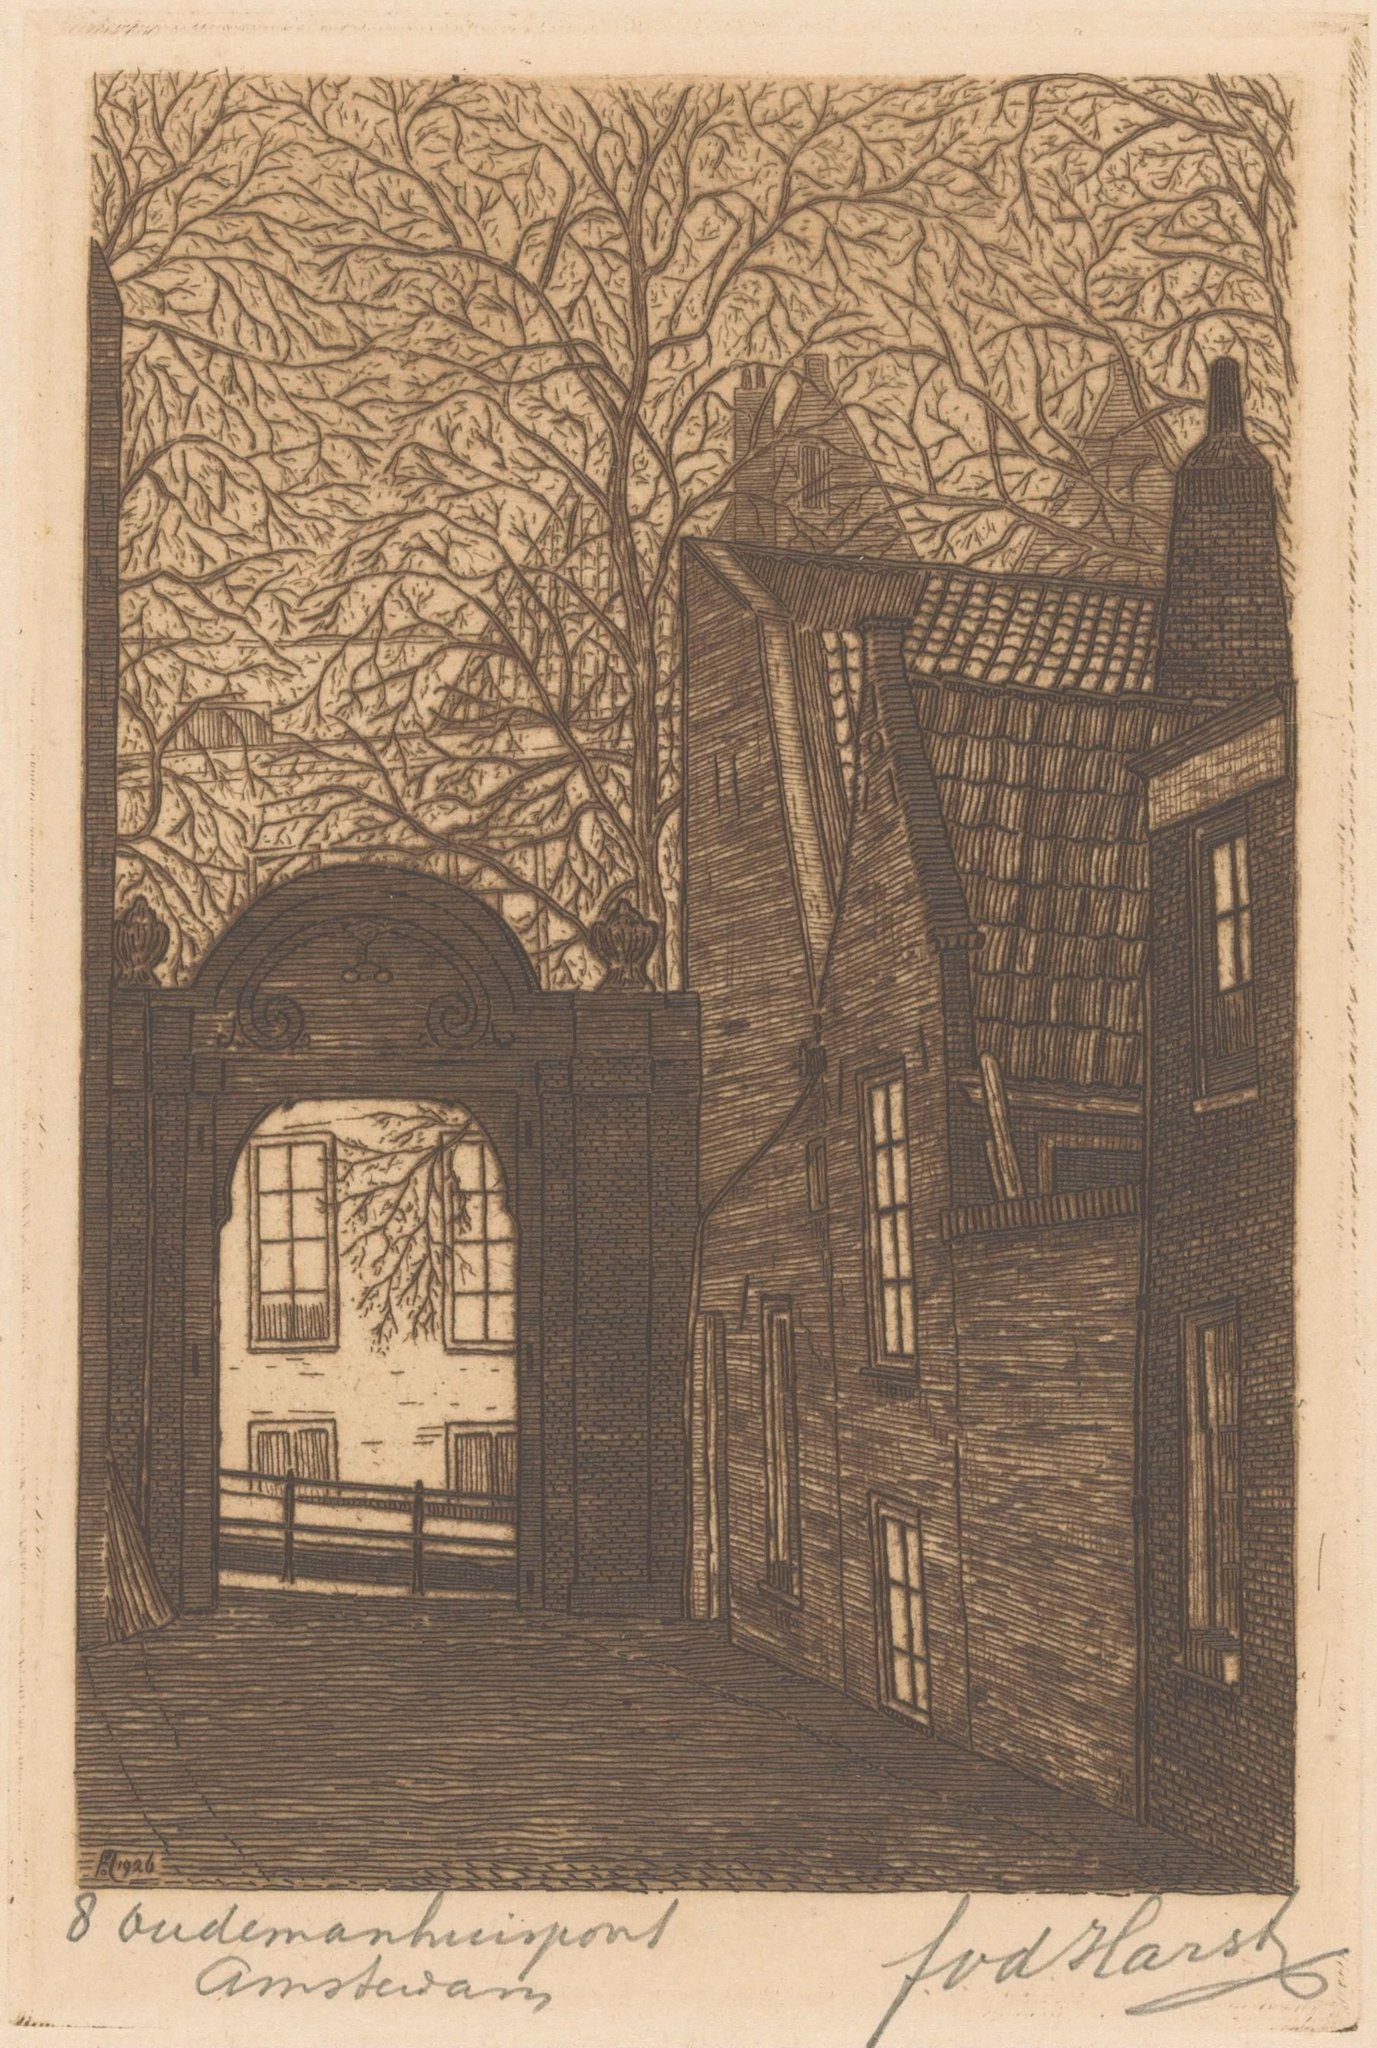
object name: print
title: Oudemanhuispoort in Amsterdam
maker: frederik van der harst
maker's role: print maker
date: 1926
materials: paper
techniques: etching, intaglio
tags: gate, entrance, lane, alley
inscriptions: collector's mark: Lugt 2228, number: ‘8’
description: De toegangspoort van het gebouwencomplex Oudemanhuispoort aan de Oudezijds Achterburgwal in Amsterdam.